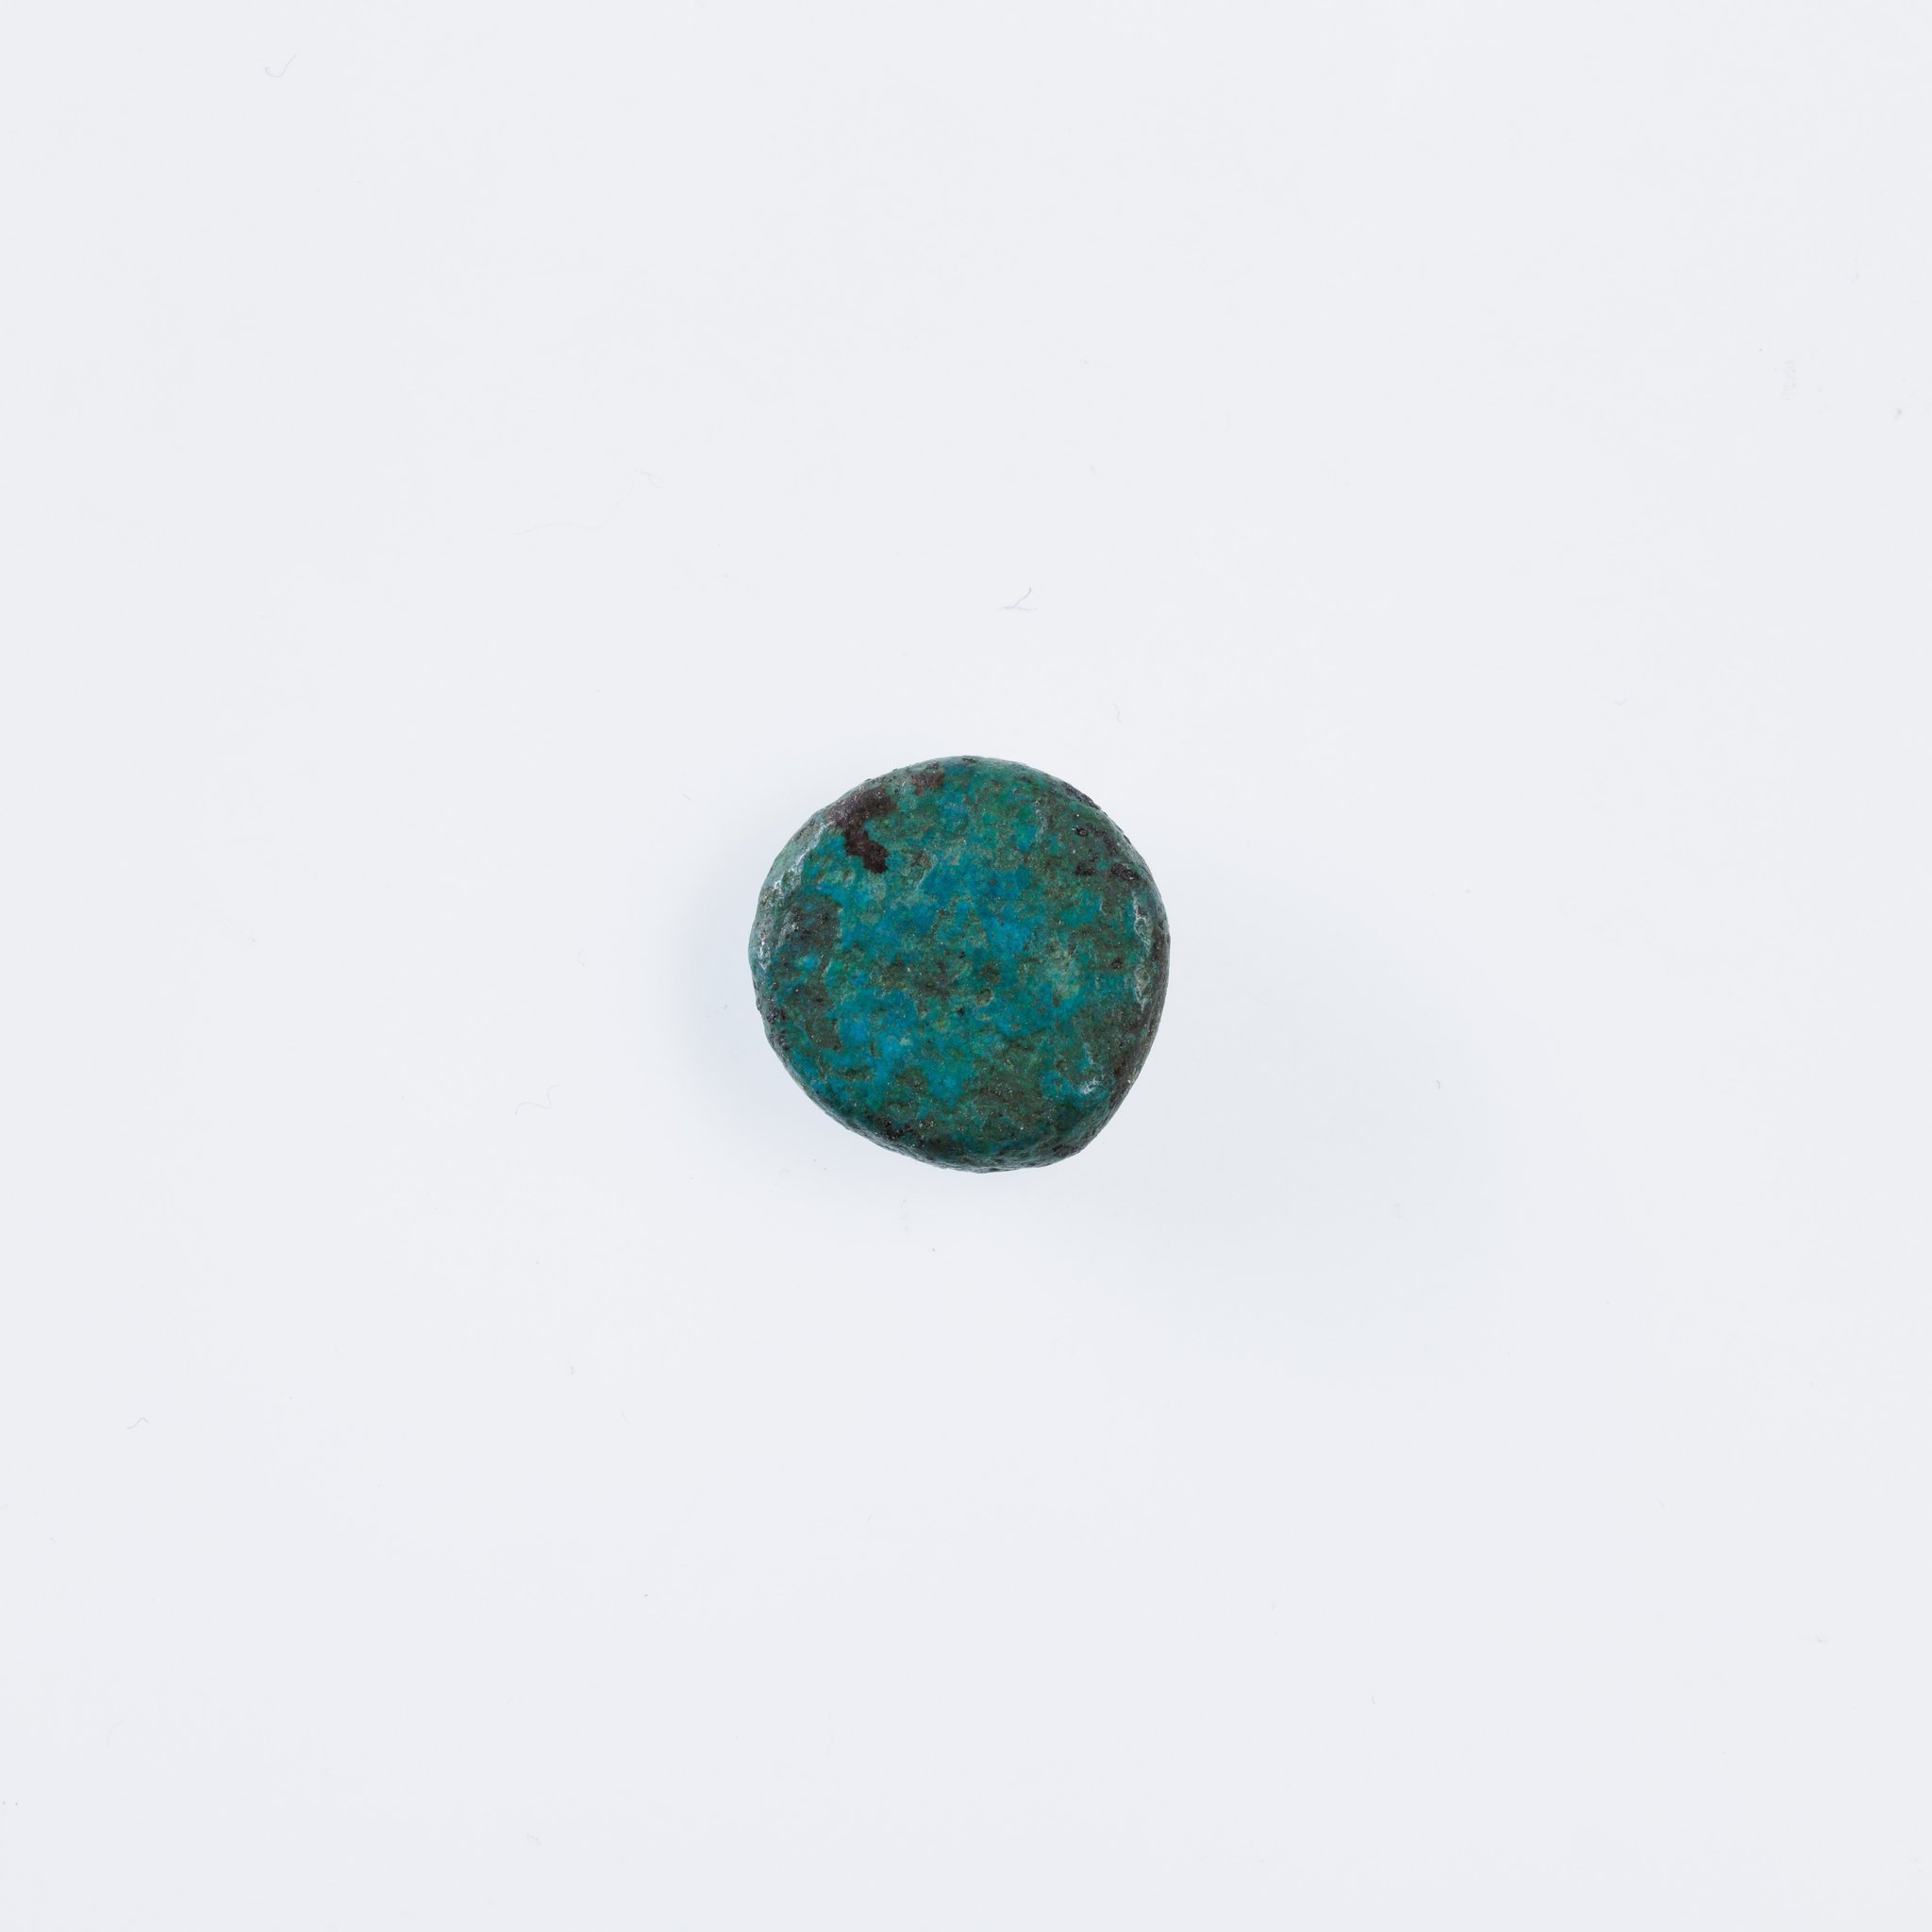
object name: weight, 1 4 kedet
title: 1/8 Qedet weight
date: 664-630 BCE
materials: bronze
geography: egypt